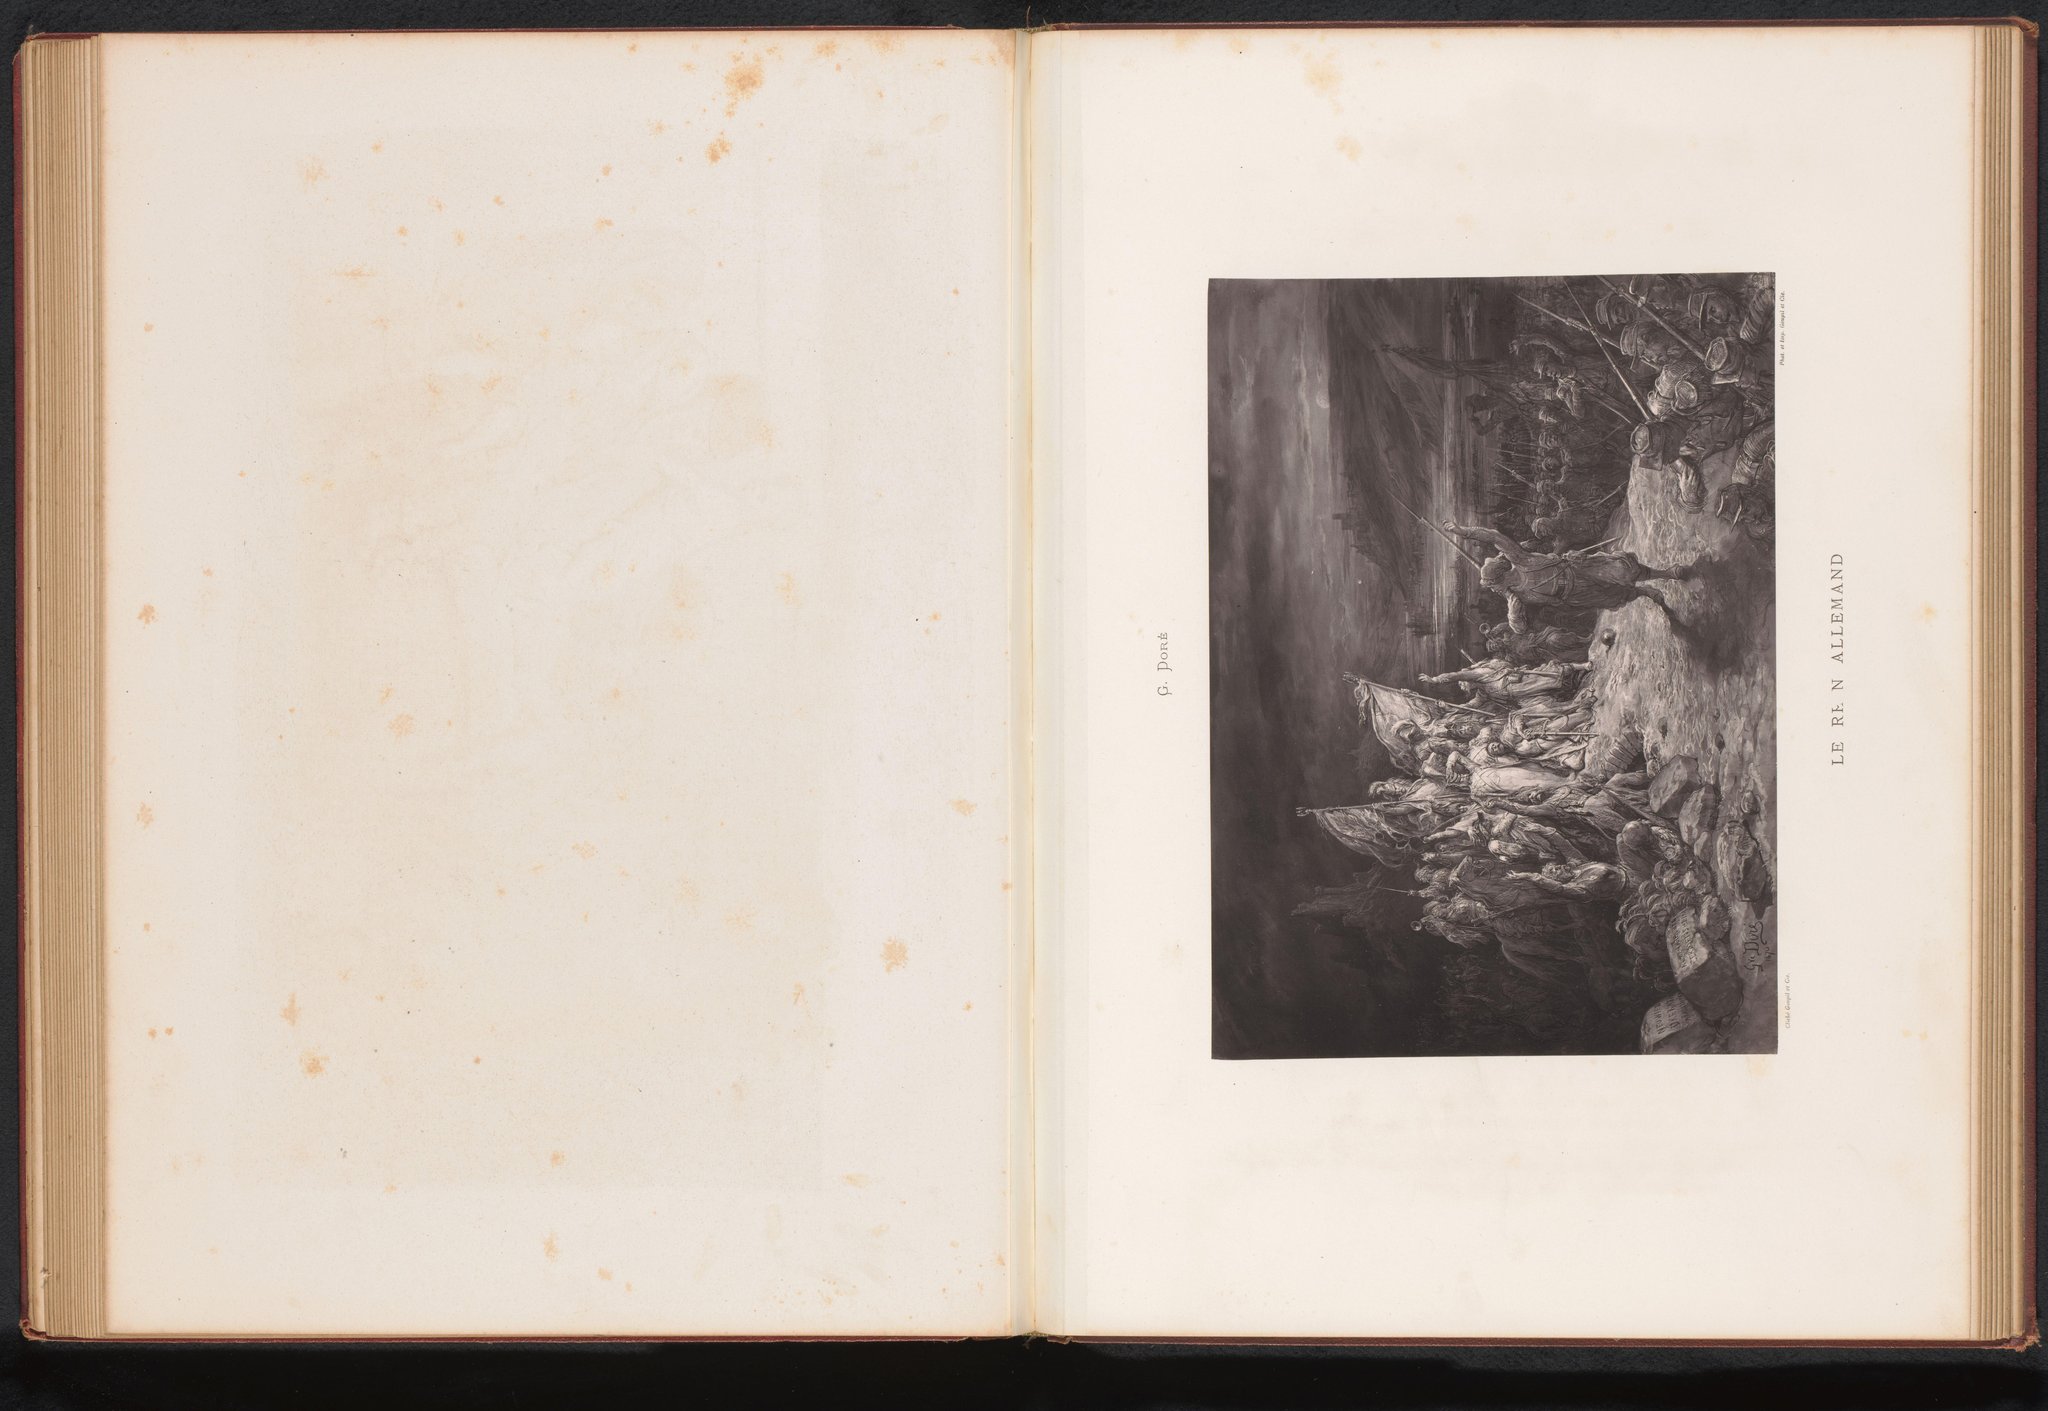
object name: page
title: Le Rhin Allemand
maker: gustave doré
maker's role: draughtsman, print maker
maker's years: 1832-1883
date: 1874-1879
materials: paper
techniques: woodburytype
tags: preparation for war, land forces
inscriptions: name: ‘G. Doré’